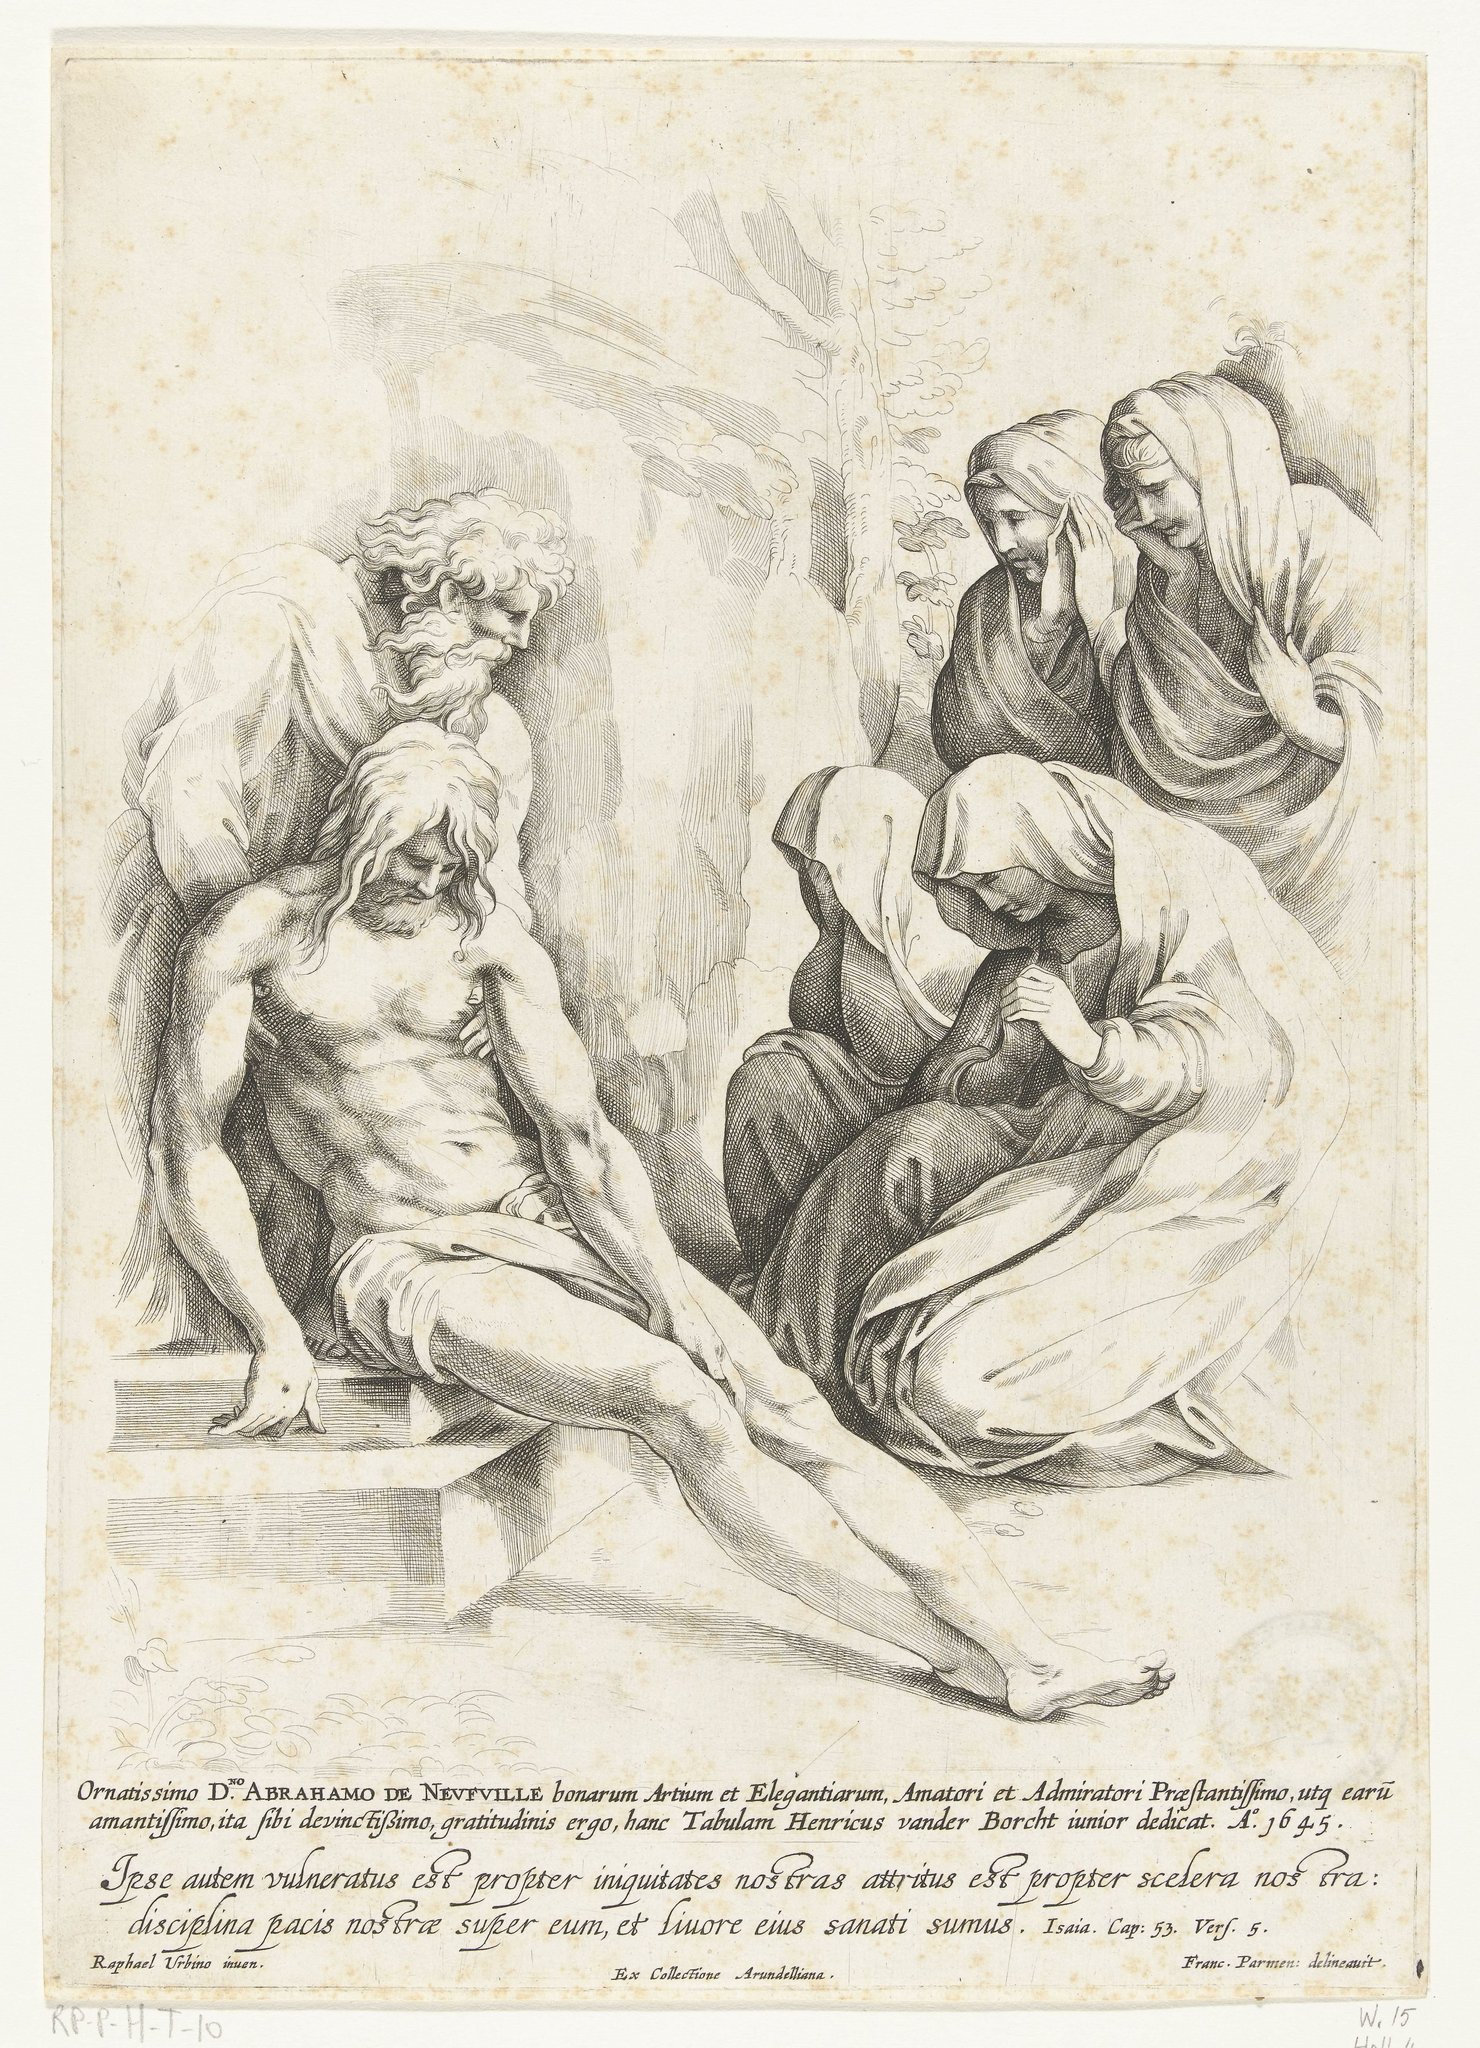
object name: print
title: Graflegging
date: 1645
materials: paper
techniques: engraving, etching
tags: christ's entombment (possibly by angels), bearing of christ's body to the grave, christ's body on or in the grave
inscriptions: collector's mark: Lugt 11, collector's mark: Lugt 10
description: Christus wordt door Jozef van Arimatea in het rotsgraf gelegd. Aan de rechterkant een groep treurende vrouwen waaronder Maria en Maria Magdelena. (Matteüs 27:57-61). De prent heet twee Latijnse onderschriften.